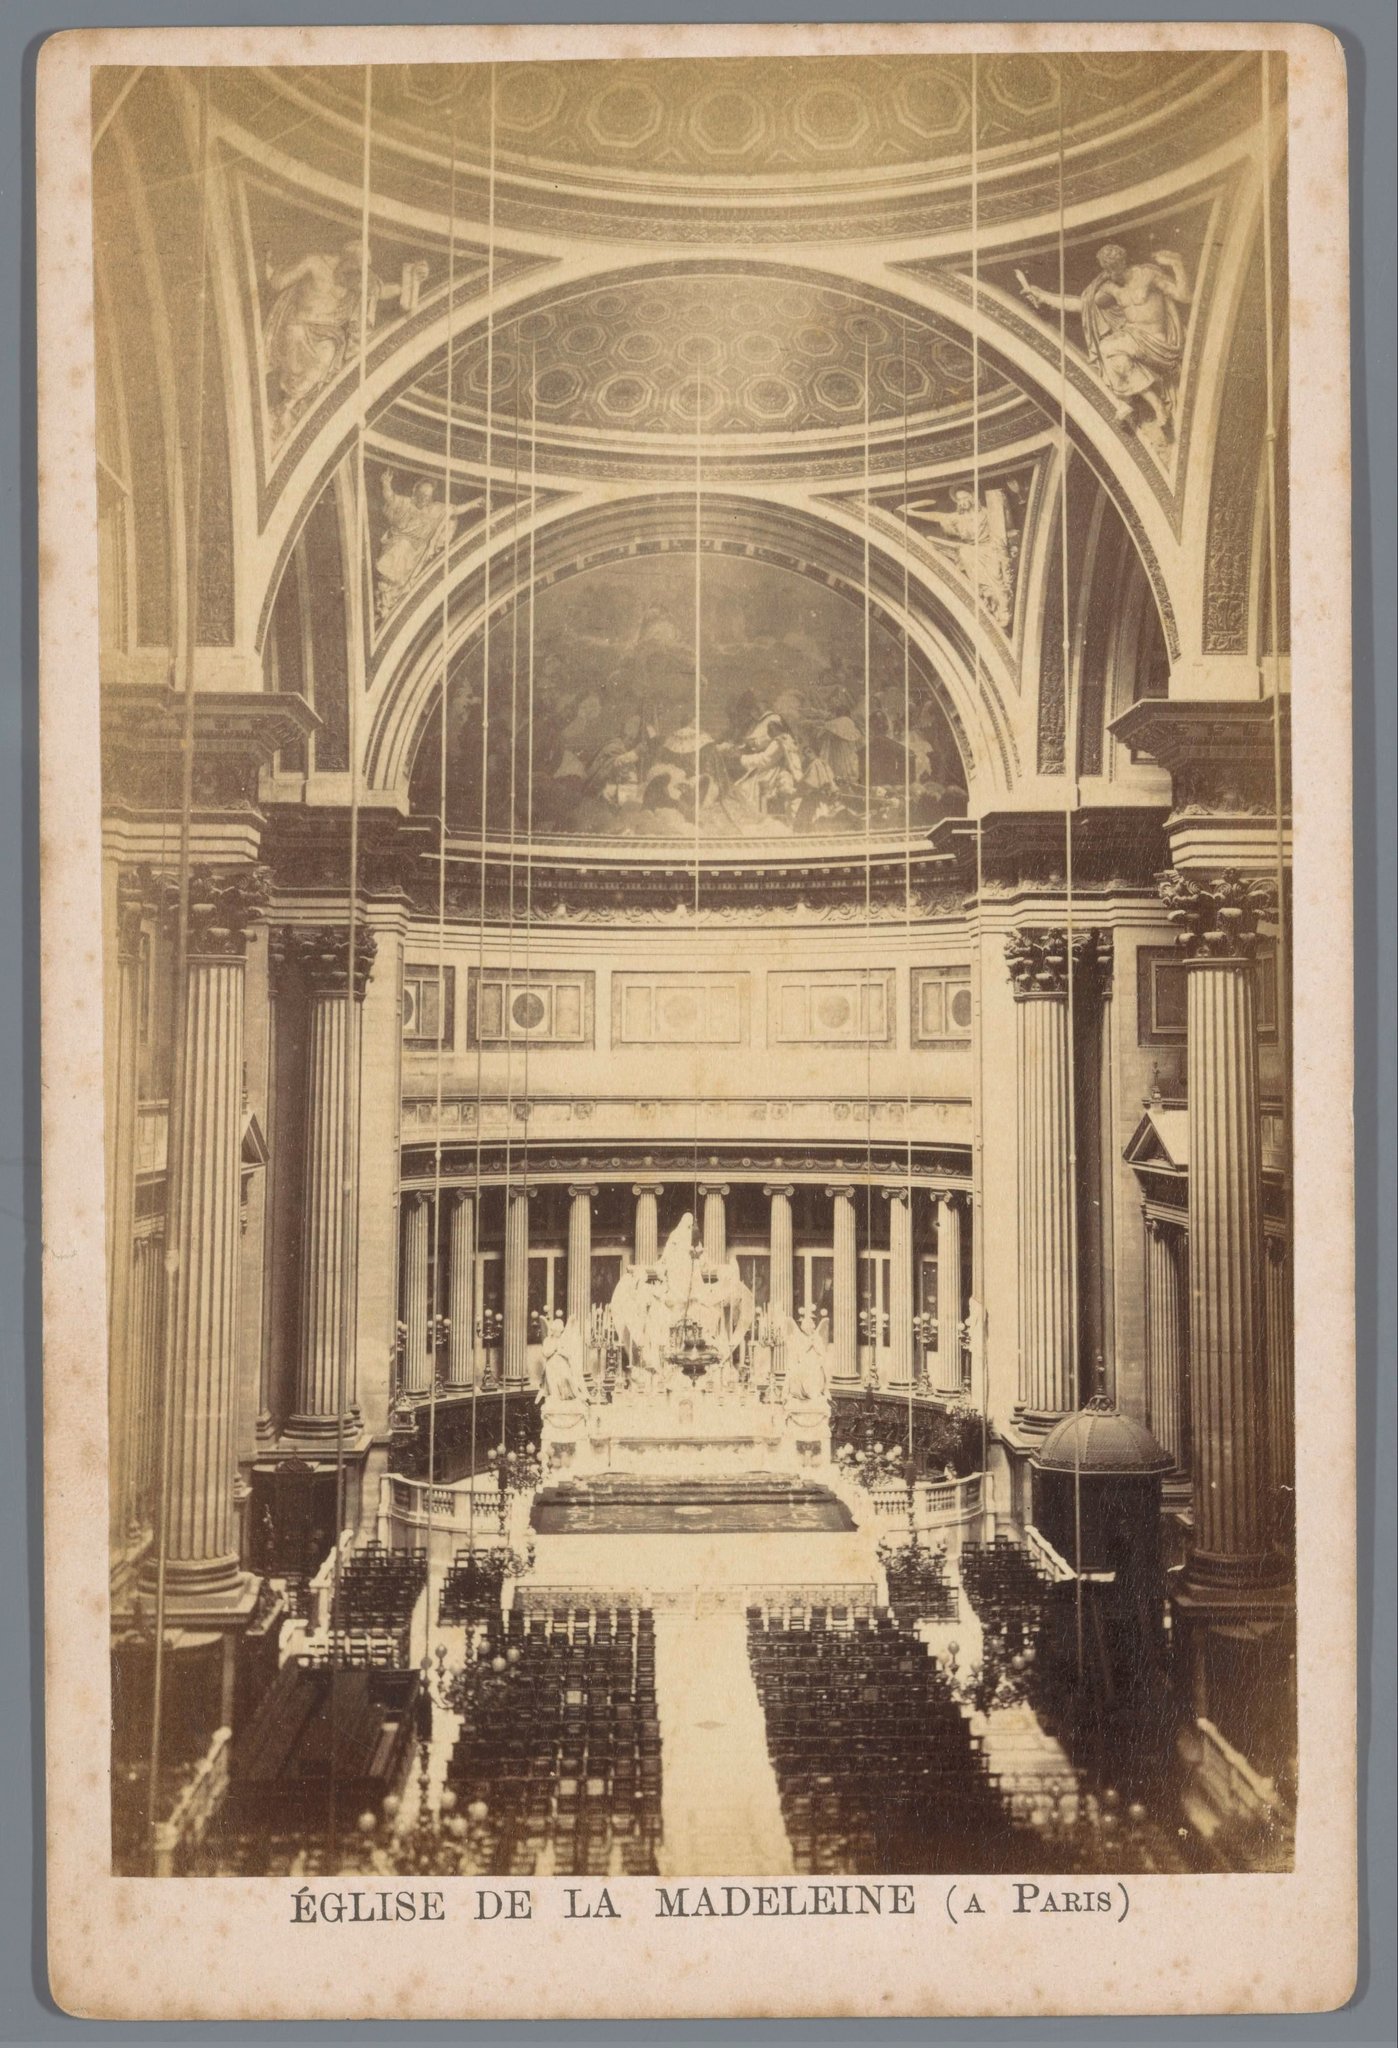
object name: cabinet photograph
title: Gezicht op het koor van La Madeleine te Parijs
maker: Anonymous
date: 1865-1875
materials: cardboard, photographic support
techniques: albumen print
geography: madeleine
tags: parts of church interior: choir